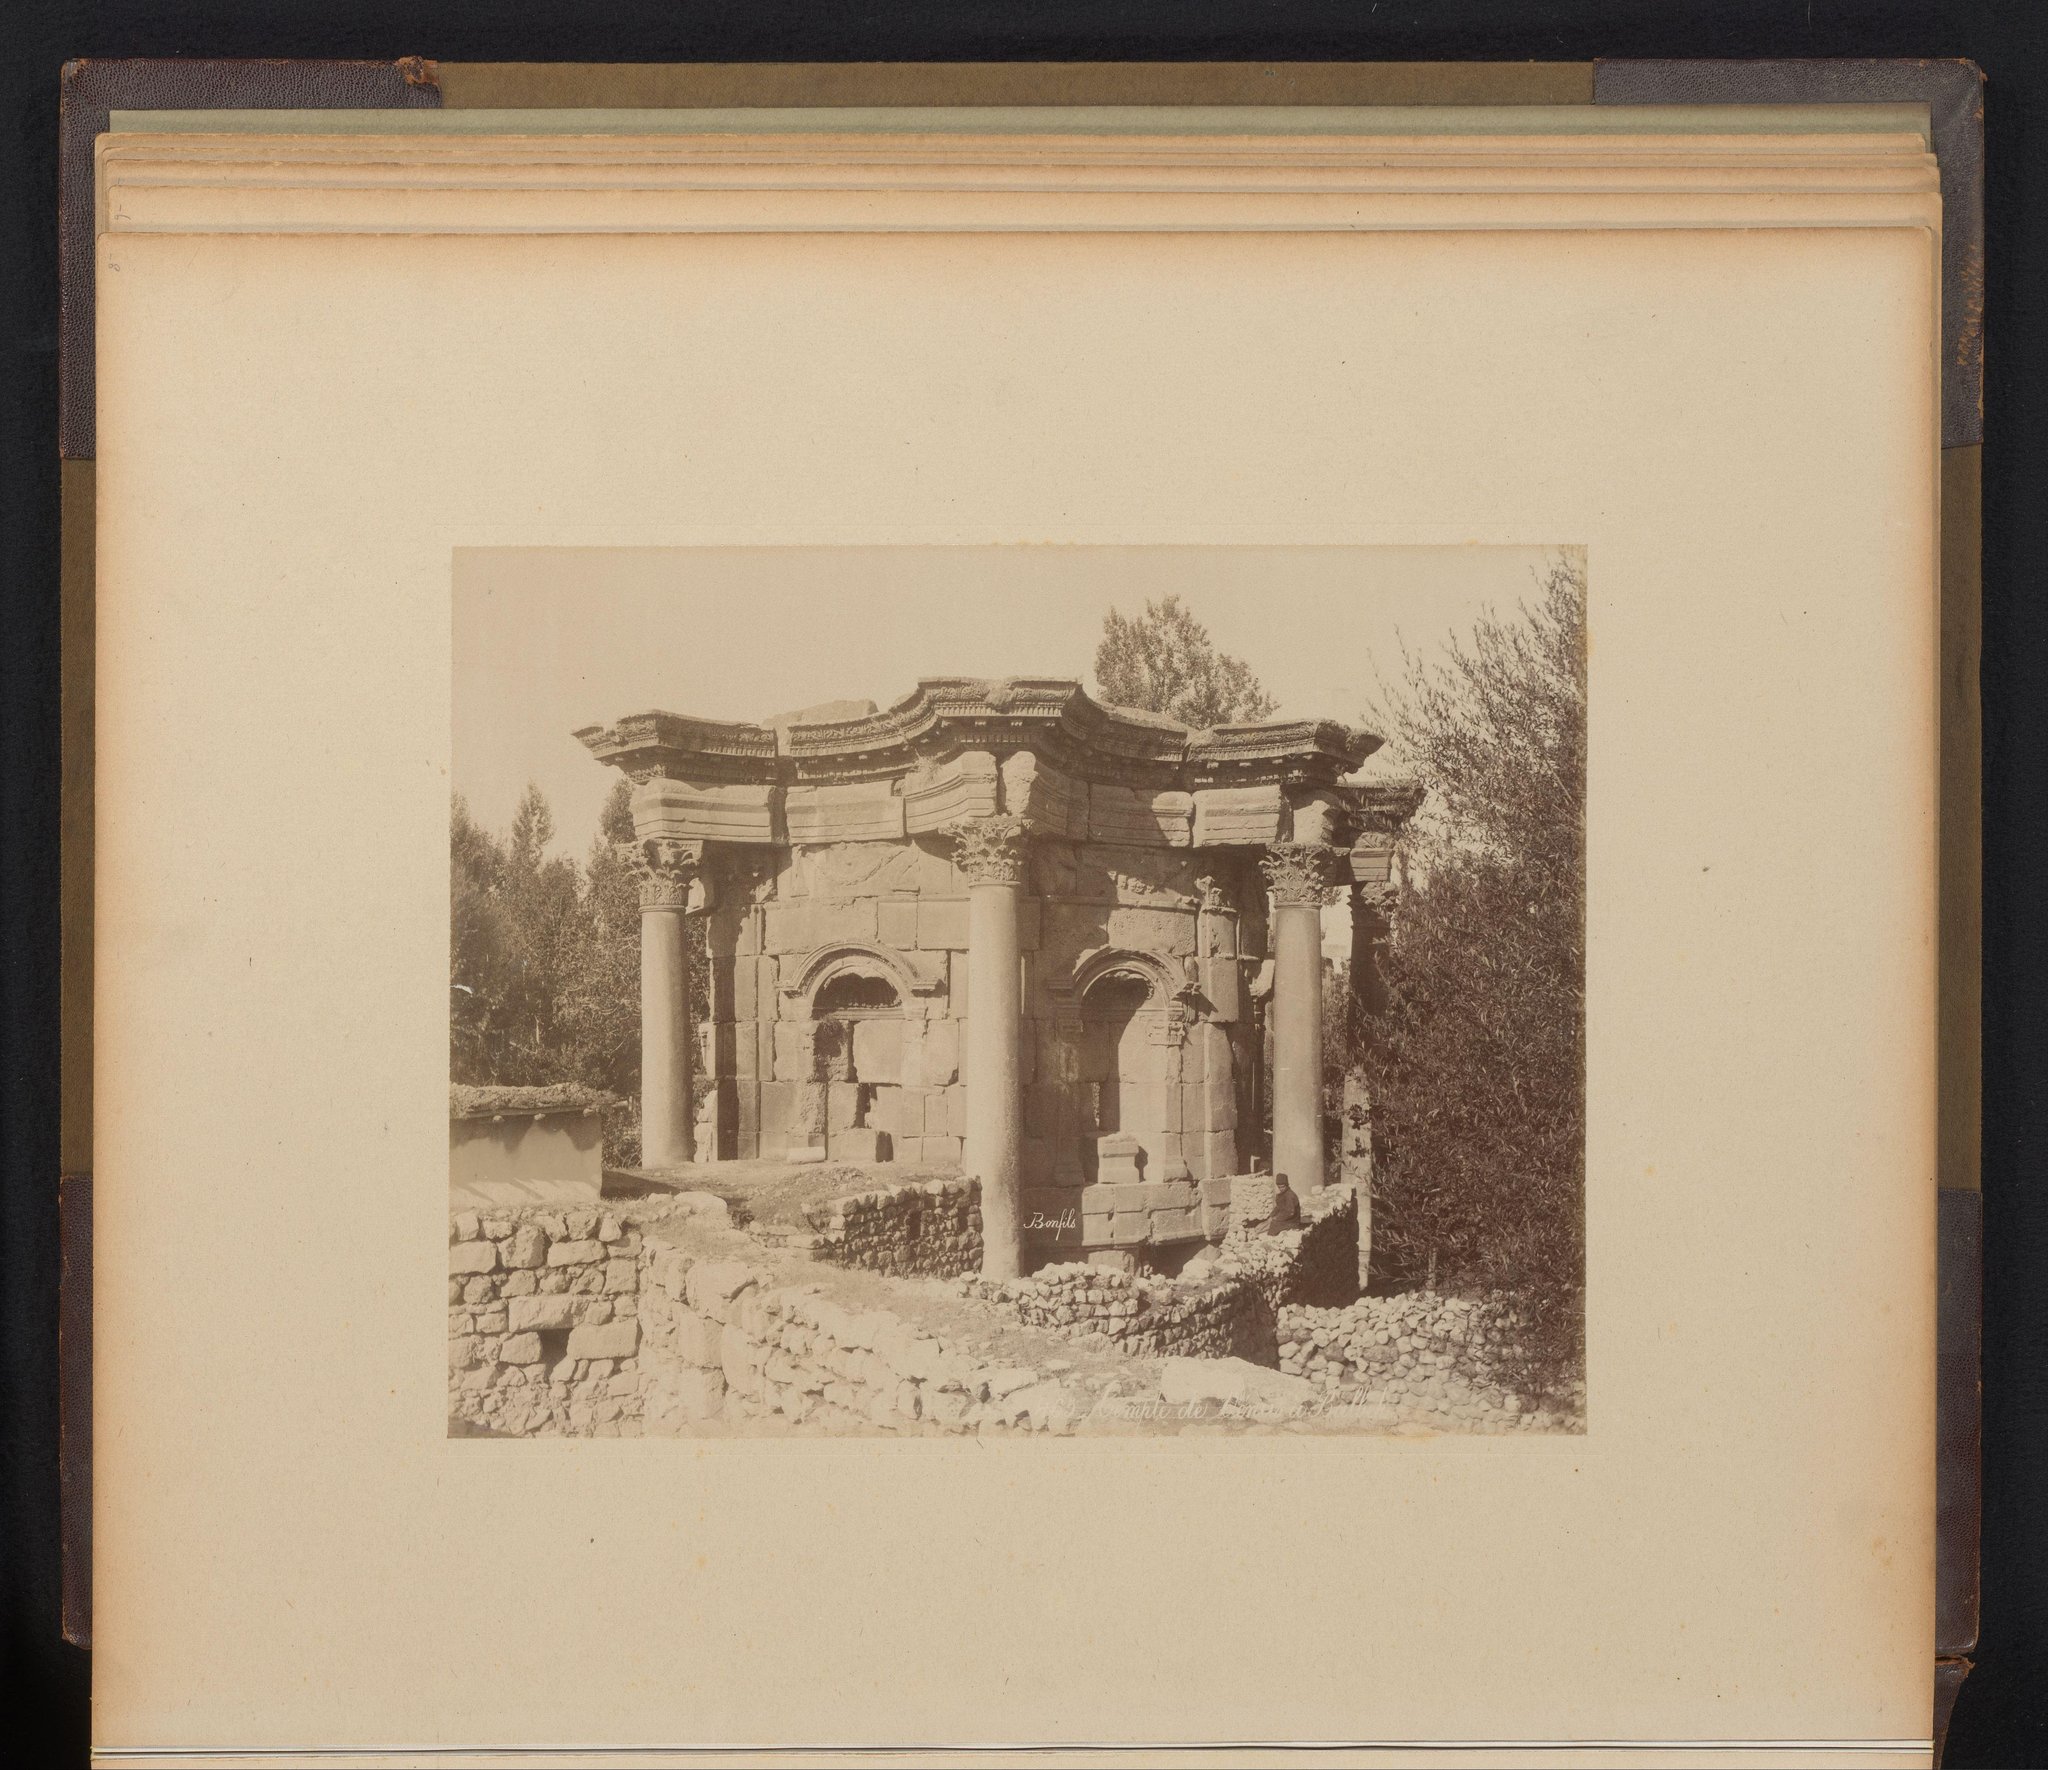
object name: photograph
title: Gezicht op de Venustempel in Baalbek, Libanon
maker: félix bonfils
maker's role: fotograaf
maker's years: 1831-1885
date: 1867-1885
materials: paper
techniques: albumen print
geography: baalbek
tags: landscape with ruins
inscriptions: number: ‘465’